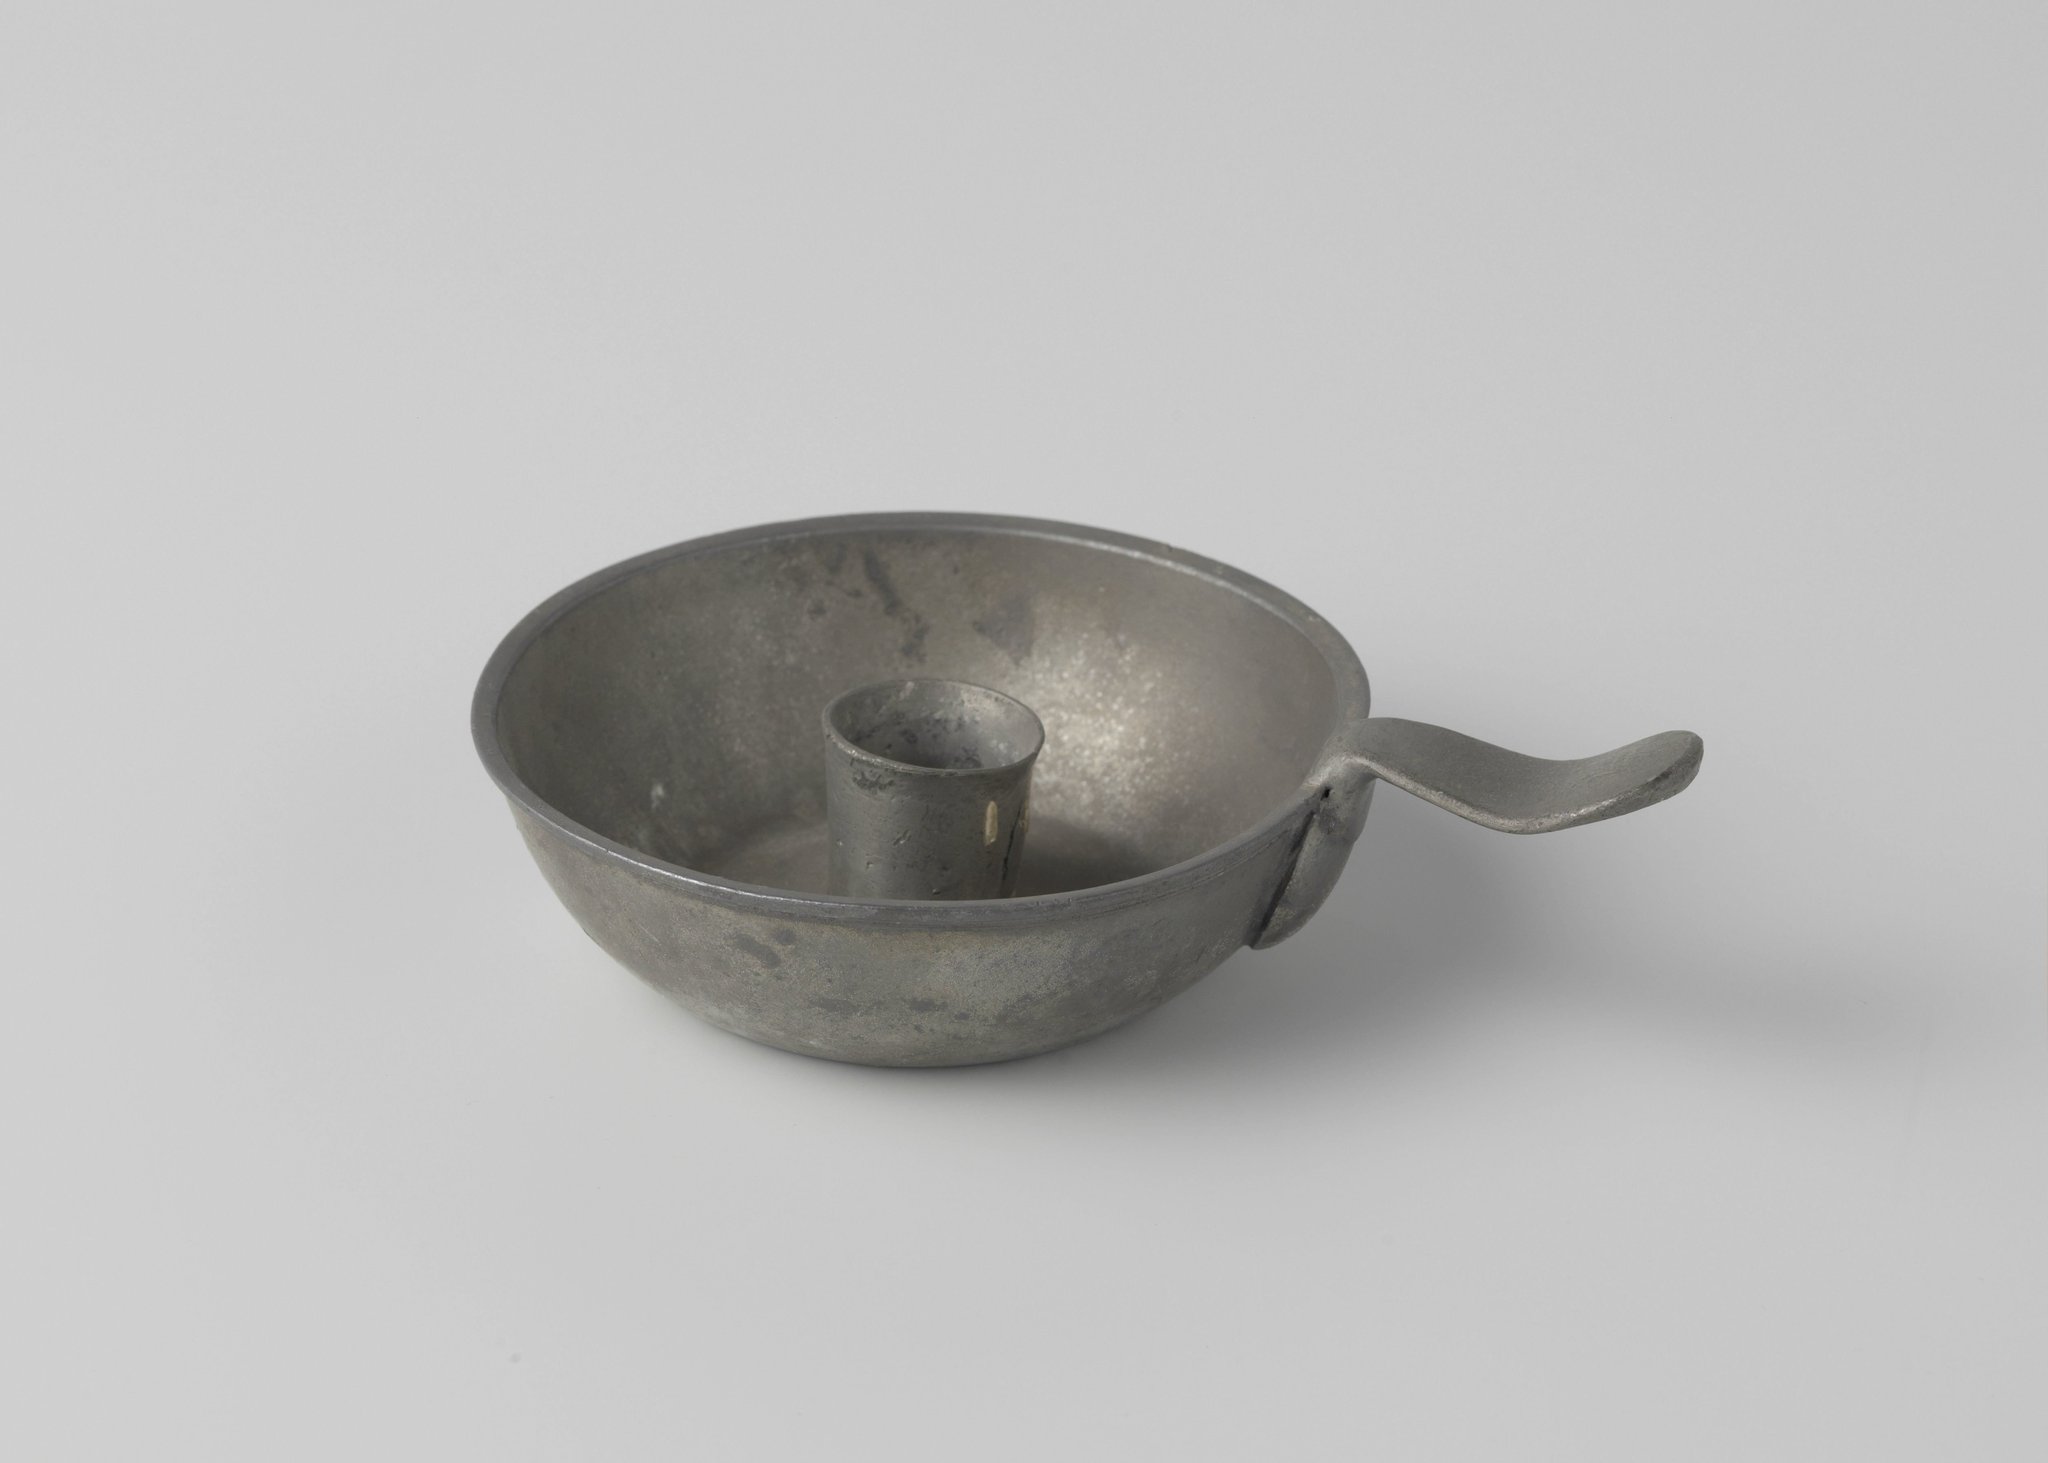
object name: chamberstick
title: Blaker van tin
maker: Anonymous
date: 1600-1800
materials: tin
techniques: casting, turning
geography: netherlands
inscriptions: quality mark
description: Ronde blaker van tin. De diepe vetvanger heeft in het midden een kaarsenhouder, die net onder de rand van de vetvanger blijft. Een handvat is aangezet, dat in het midden iets naar beneden doorhelt.